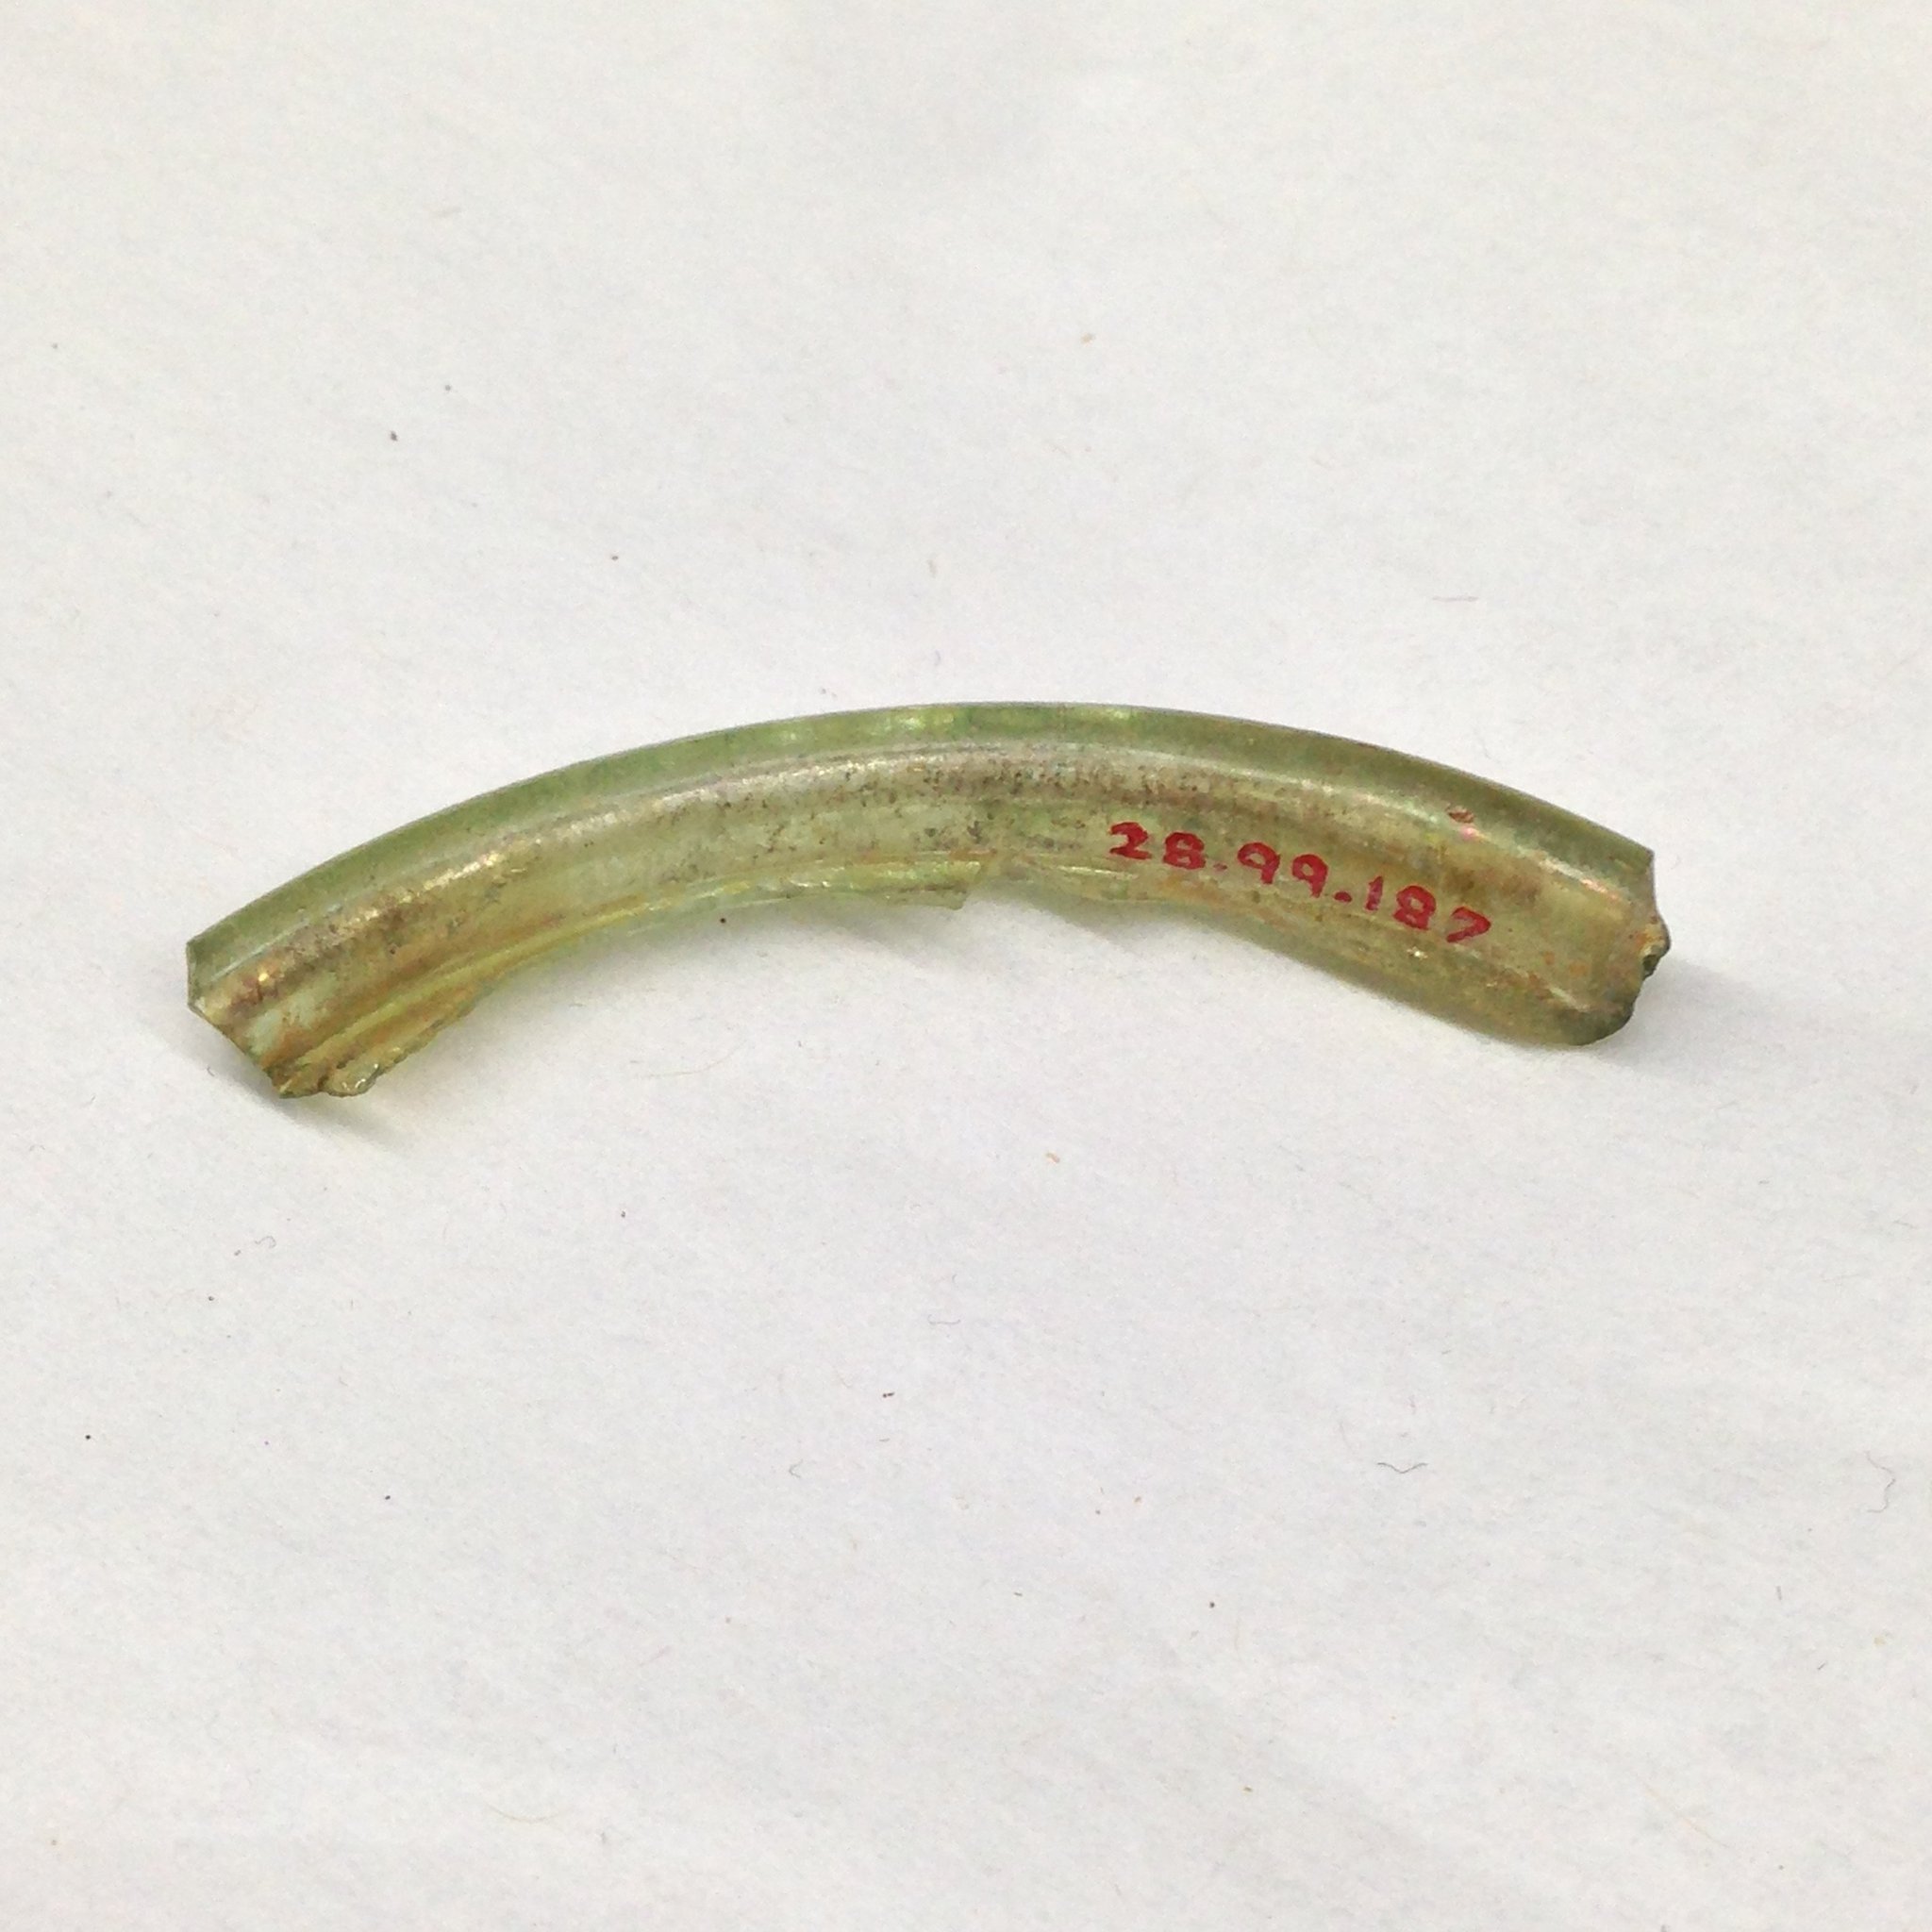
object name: fragment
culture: european or middle eastern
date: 1150-1250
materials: ceramic, glass